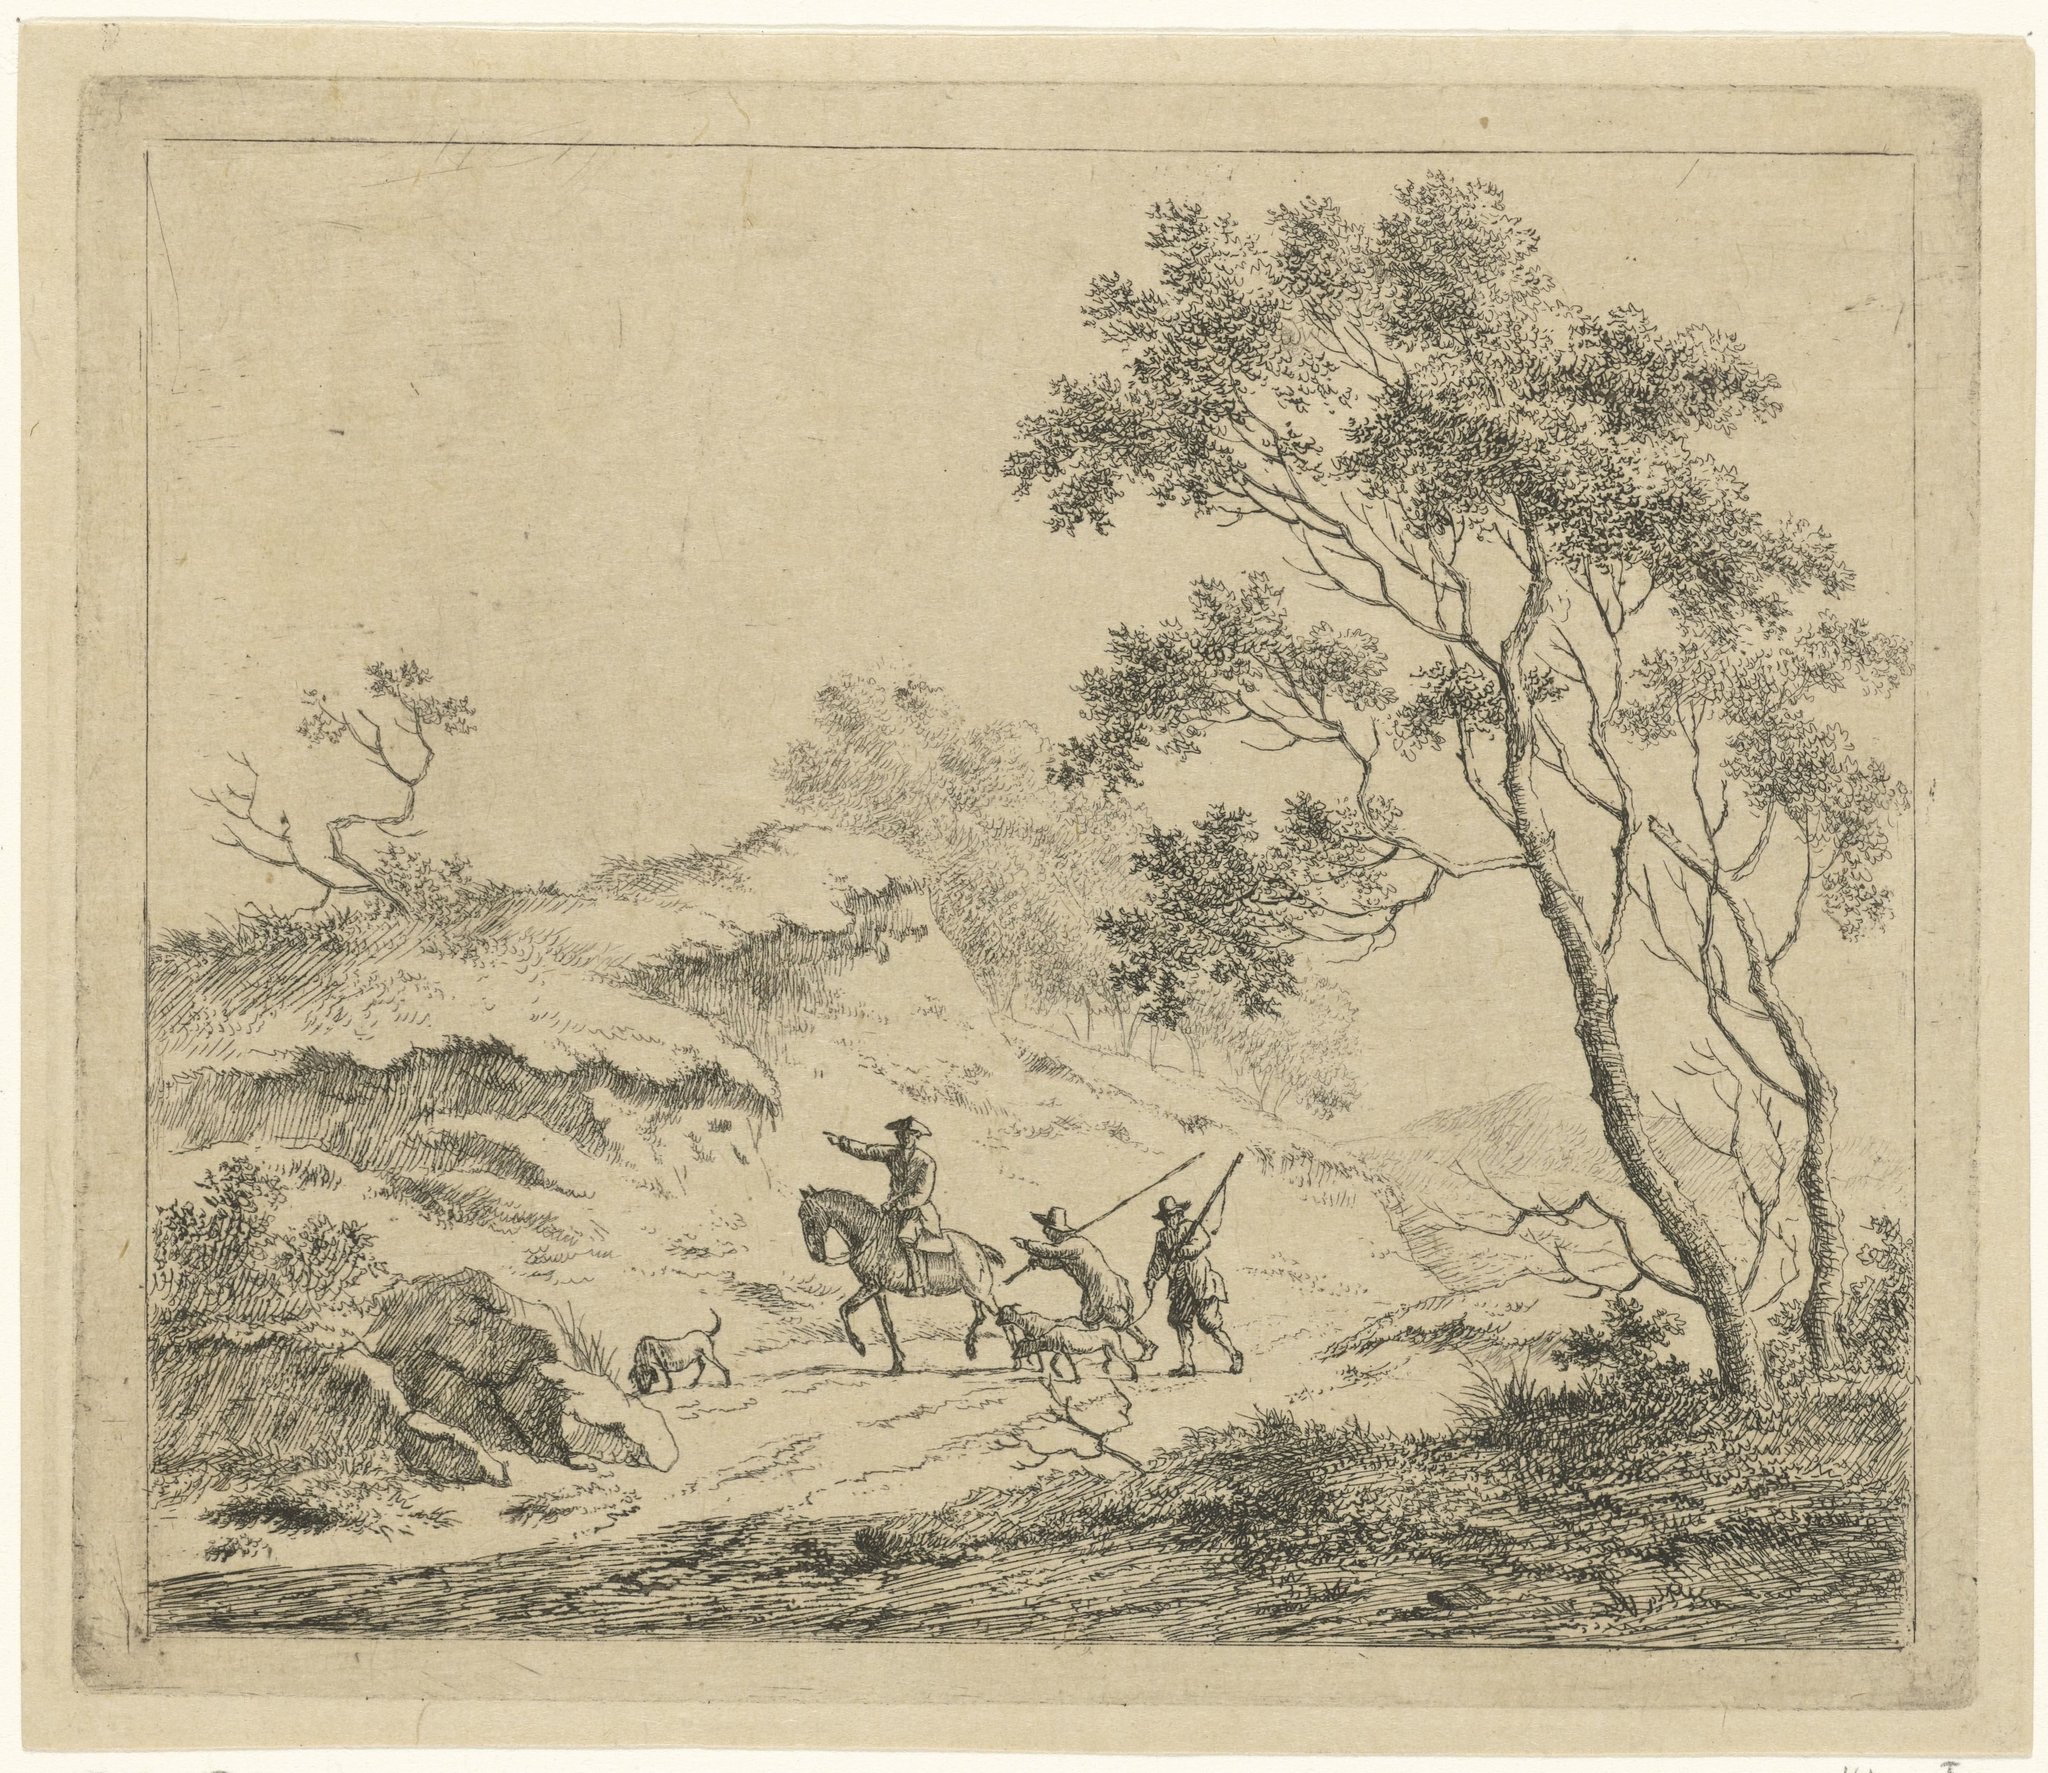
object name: print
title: September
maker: johannes janson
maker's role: draughtsman, painter, print maker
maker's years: 1729-1784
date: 1783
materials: paper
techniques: etching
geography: leiden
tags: landscape symbolizing september, hunting, chase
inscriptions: collector's mark: Lugt 240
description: Bergachtig landschap met ruiter, twee mannen en drie honden op een pad. Vóór de lucht. Tiende prent uit een serie van dertien met maanden.